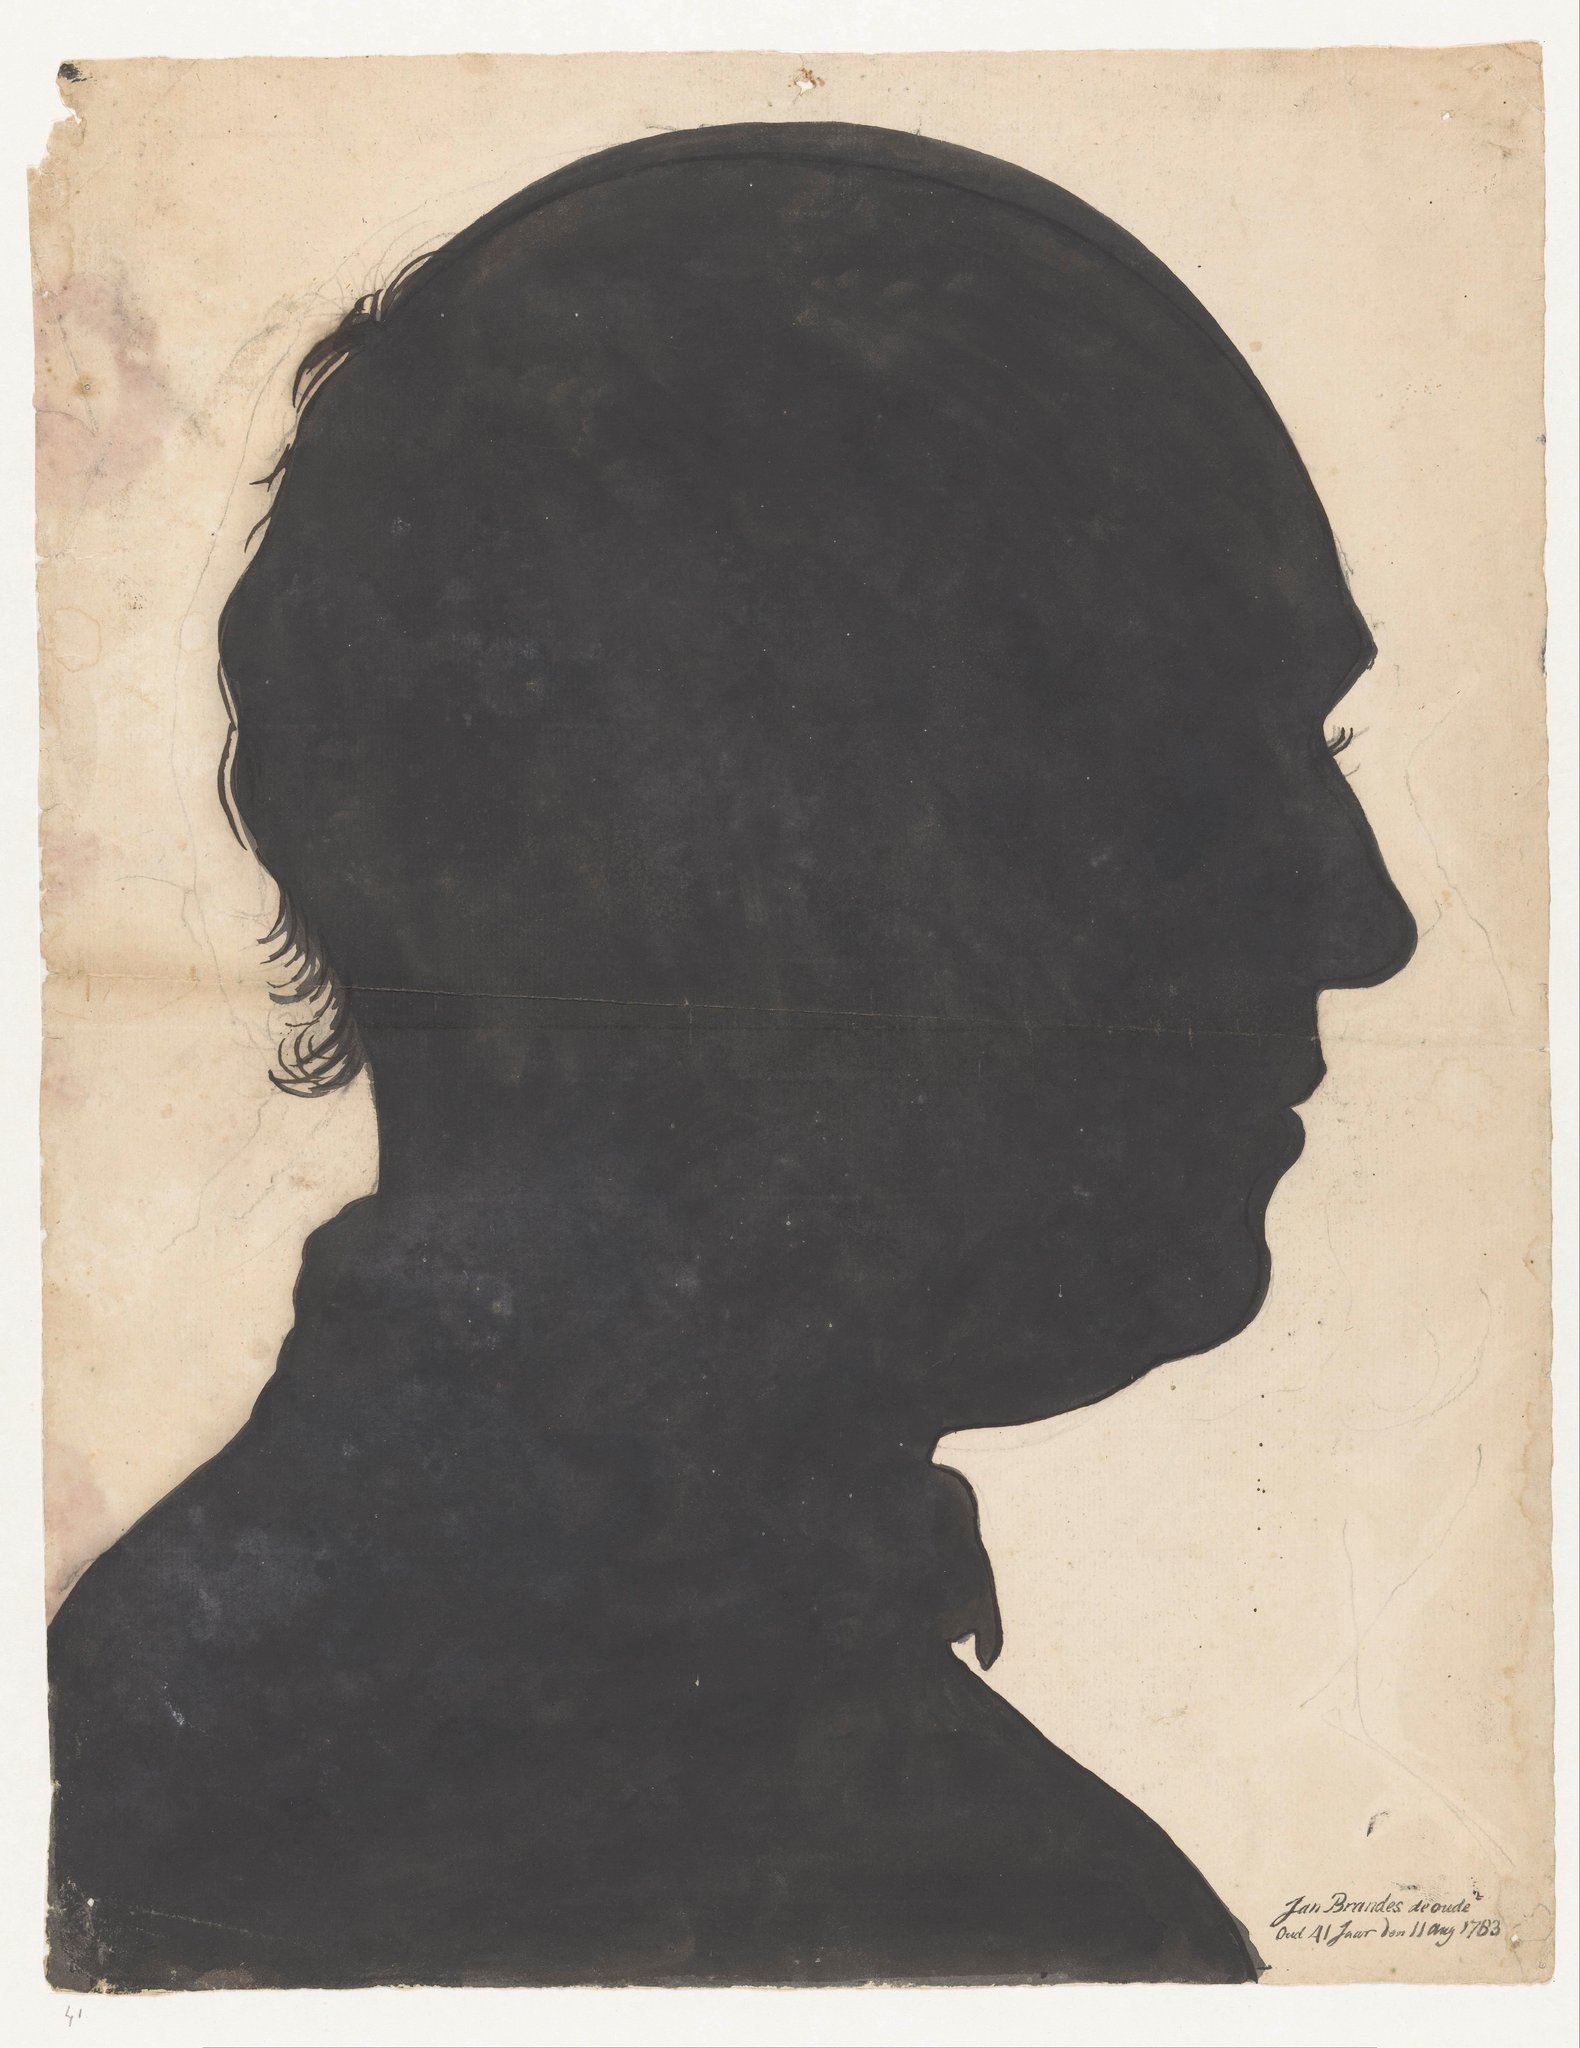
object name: drawing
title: Silhouetportret van Jan Brandes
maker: jan brandes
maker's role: draughtsman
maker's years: 1743-1808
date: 1783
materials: paper, pencil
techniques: brush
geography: batavia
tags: jan brandes, historical persons, portrait, self-portrait of artist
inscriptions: date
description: Zelfportret in silhouet van de tekenaar Jan Brandes op zijn 41ste verjaardag. Met opschrift.